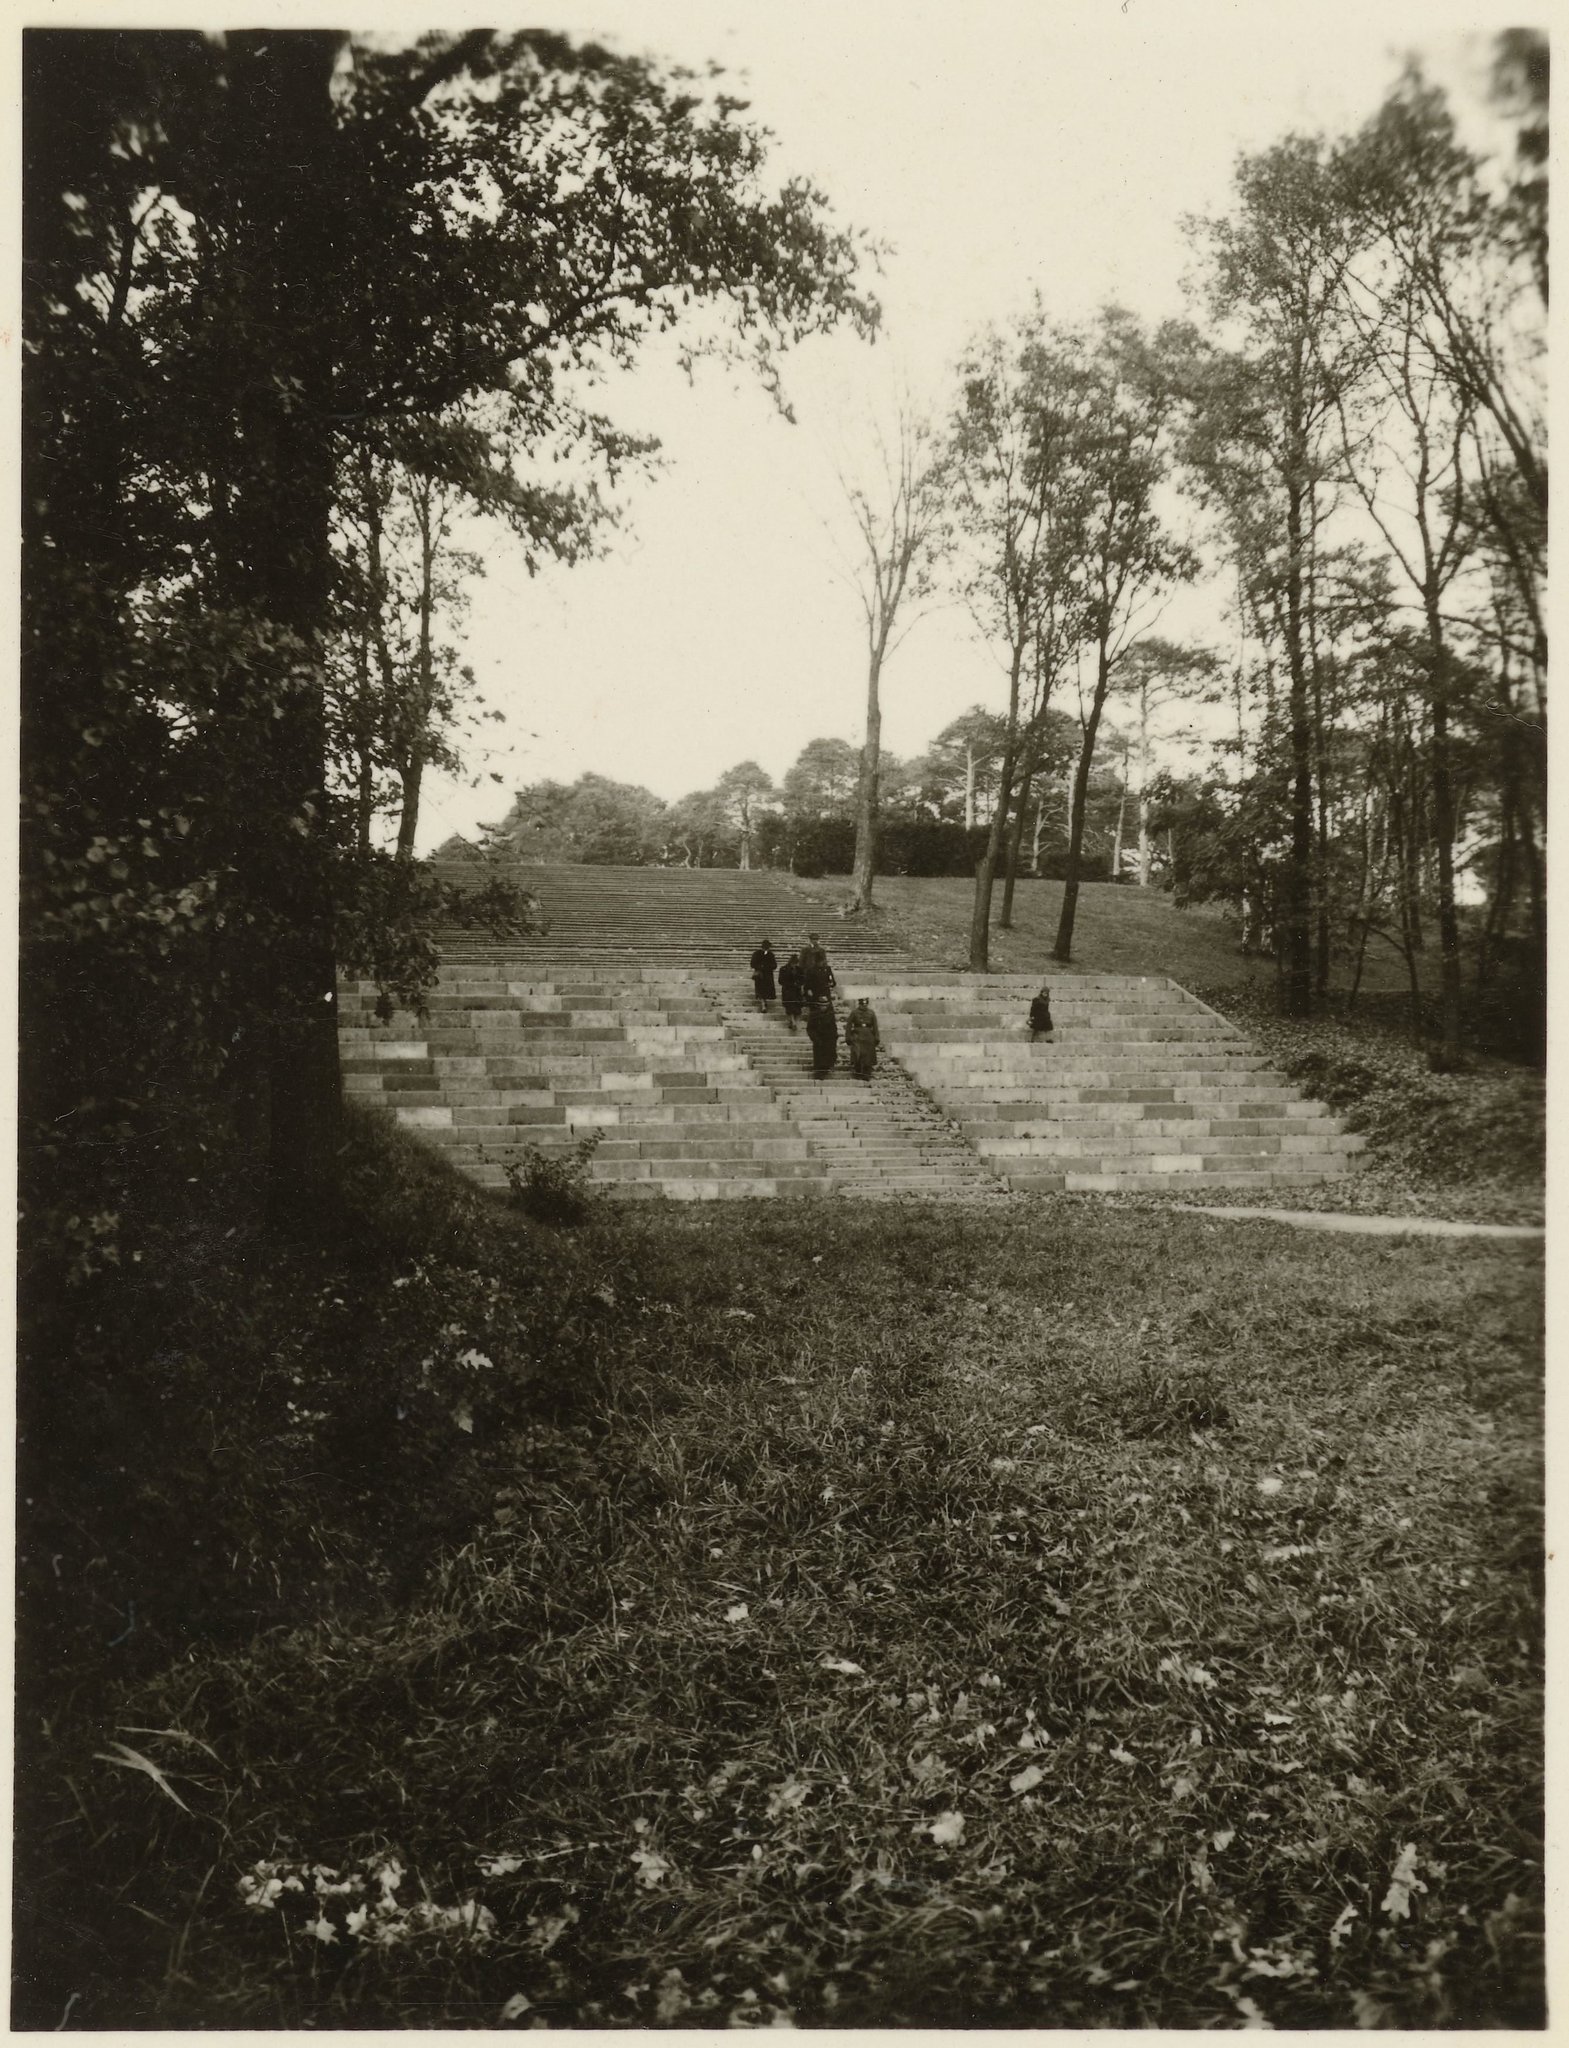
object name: photograph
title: Soldaten lopen een trap af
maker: Anonymous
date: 1940-1945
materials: photographic support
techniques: gelatin silver print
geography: czechoslovakia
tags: netherlands, germany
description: Soldaten lopen een trap af in een omgeving met bomen. Foto behorend bij album 'Kriegserinnerungen'.